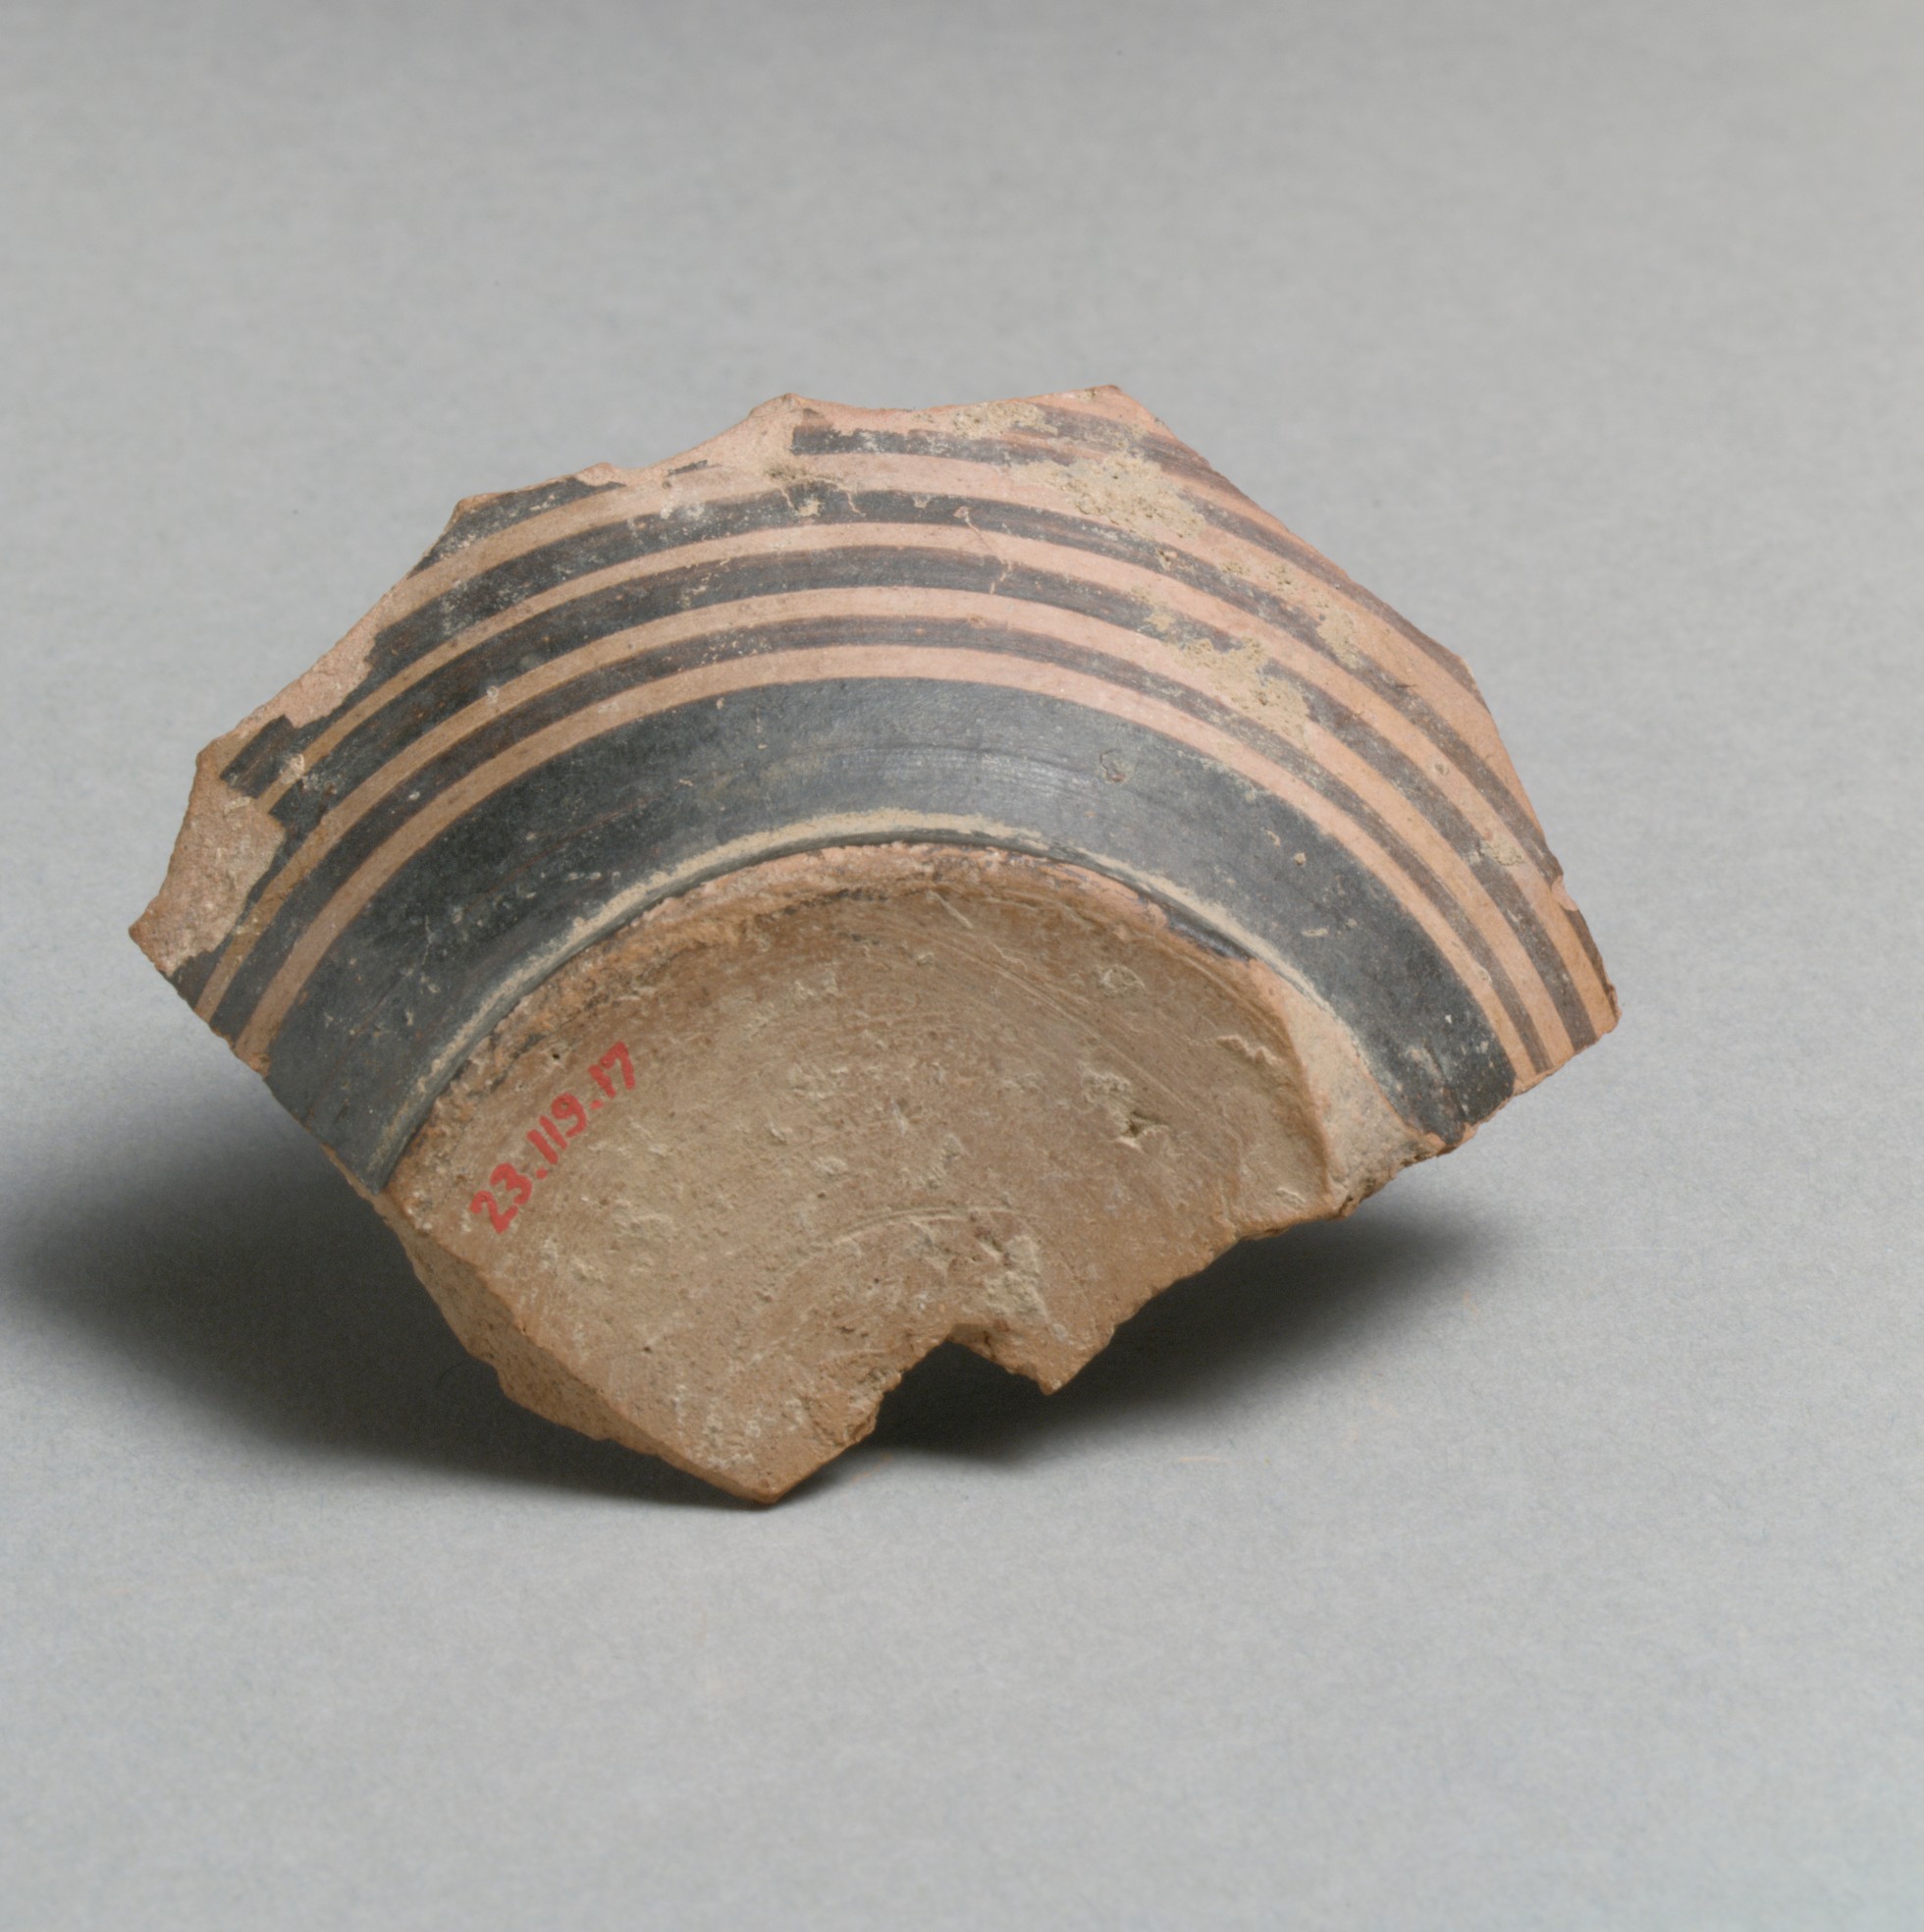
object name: vase fragment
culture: greek, laconian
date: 2000-1550 BCE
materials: terracotta